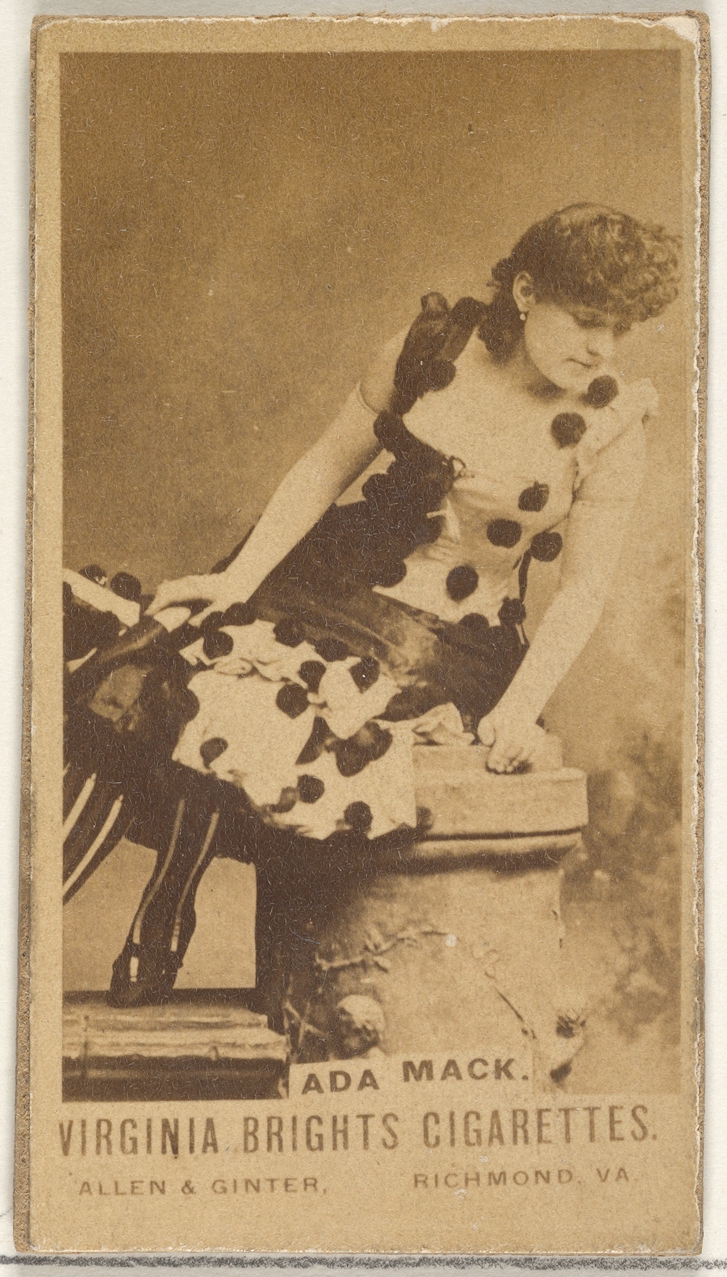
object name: photograph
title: Ada Mack, from the Actors and Actresses series (N45, Type 1) for Virginia Brights Cigarettes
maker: allen & ginter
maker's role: publisher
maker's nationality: american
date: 1888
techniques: albumen silver print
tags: portraits,women,actresses